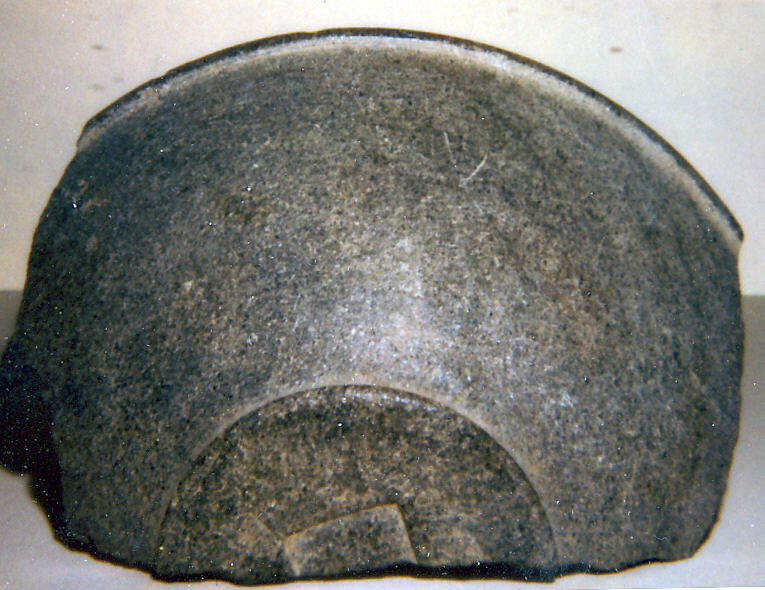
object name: fragment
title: Fragment of a Bowl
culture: gandhara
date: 1-100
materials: stone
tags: gandhara